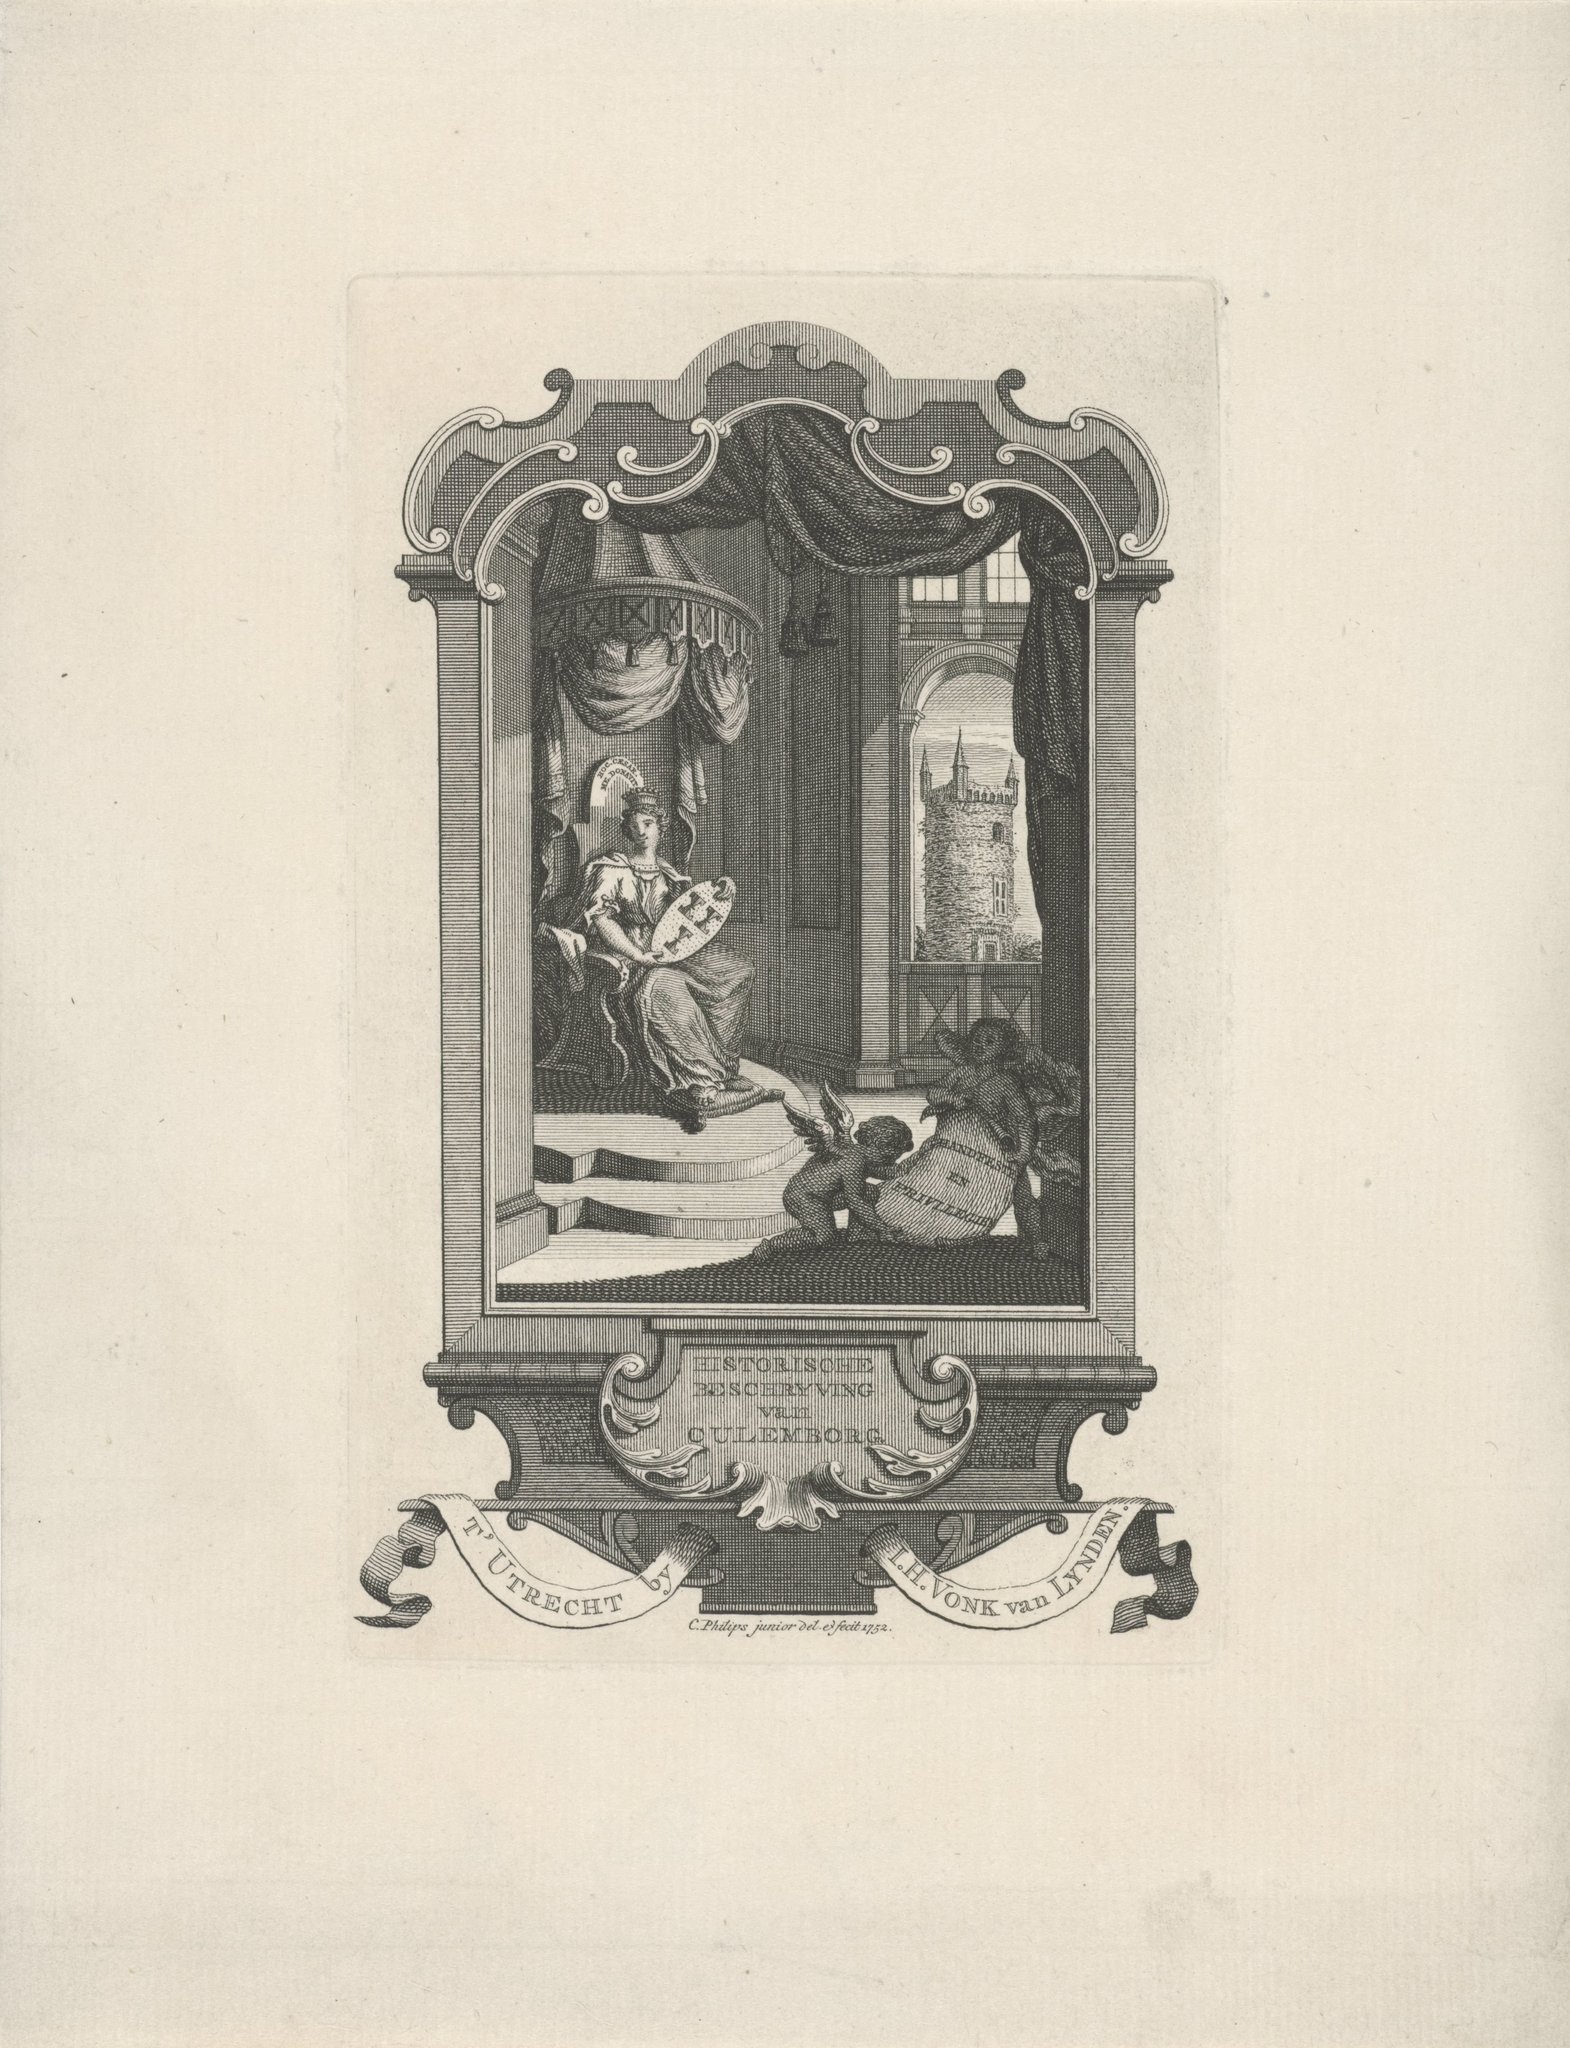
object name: titelblad, titelpagina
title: Stedenmaagd van Culemborg in kasteelvertrek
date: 1752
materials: paper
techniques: engraving, etching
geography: utrecht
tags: castle - aa - civic architecture: inside, city represented symbolically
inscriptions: collector's mark: Lugt 2228, collector's mark: Lugt 2760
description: Vignet met een kasteelvertrek. Op een troon onder een baldakijn zit de stedenmaagd van Culemborg, in haar handen het wapenschild van de stad. Op een cartouche de titel in het Nederlands.